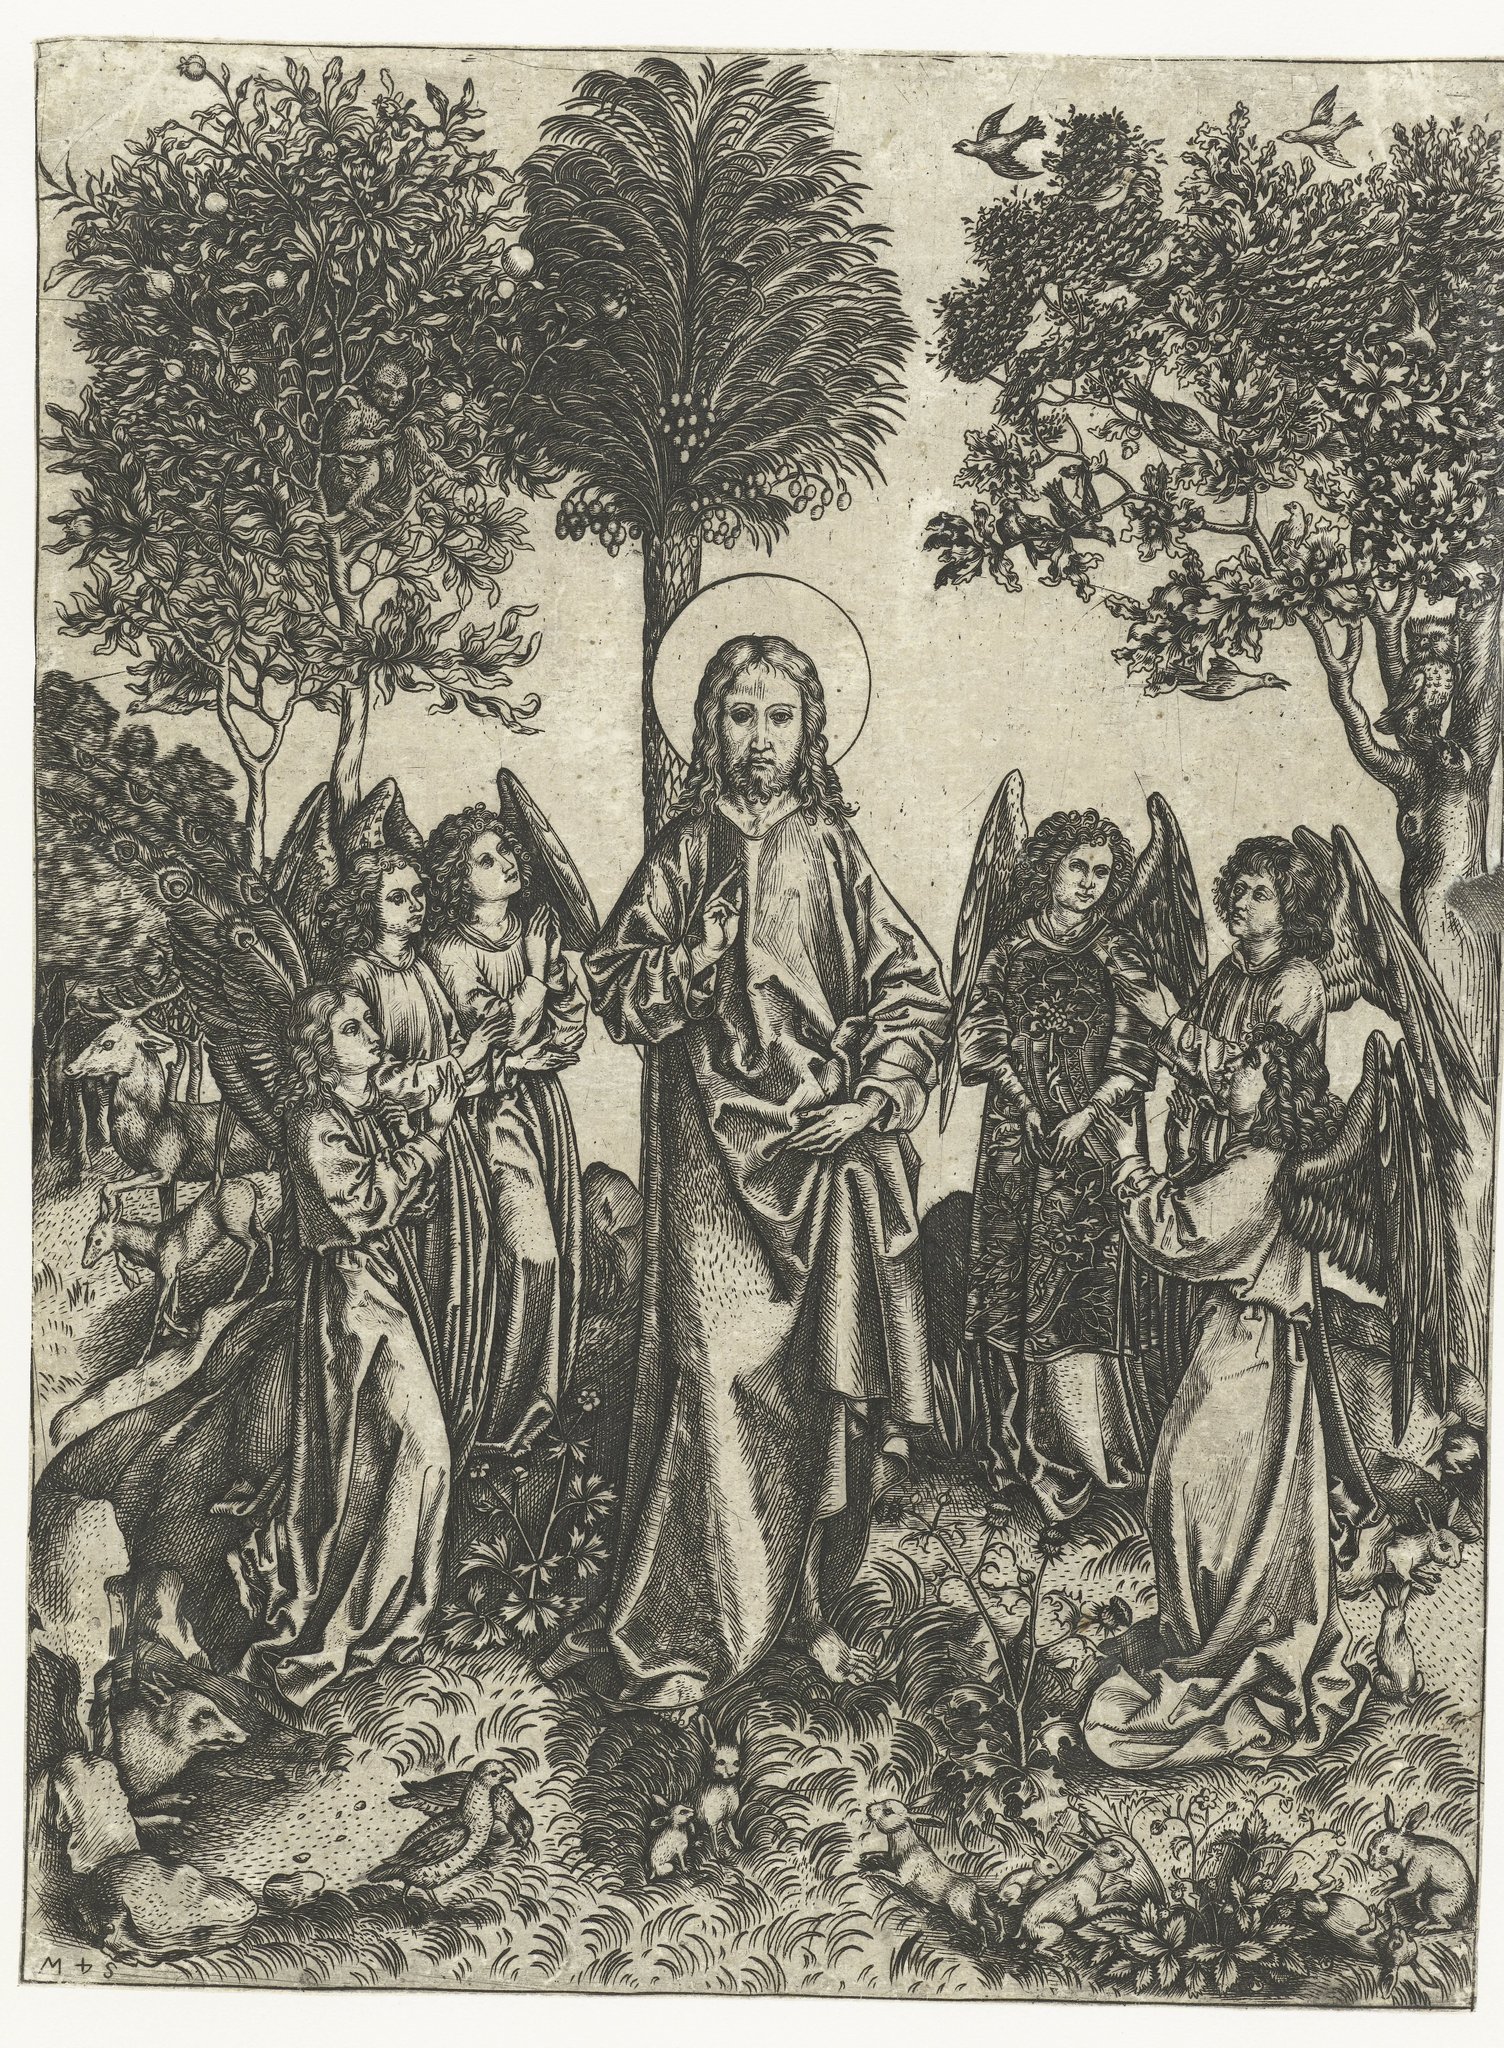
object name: print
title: Christus in de wildernis met engelen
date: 1480-1500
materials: paper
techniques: engraving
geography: bocholt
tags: adult christ together with angels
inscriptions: collector's mark: Lugt 240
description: Christus in een landschap met bomen en dieren, omringd door engelen.